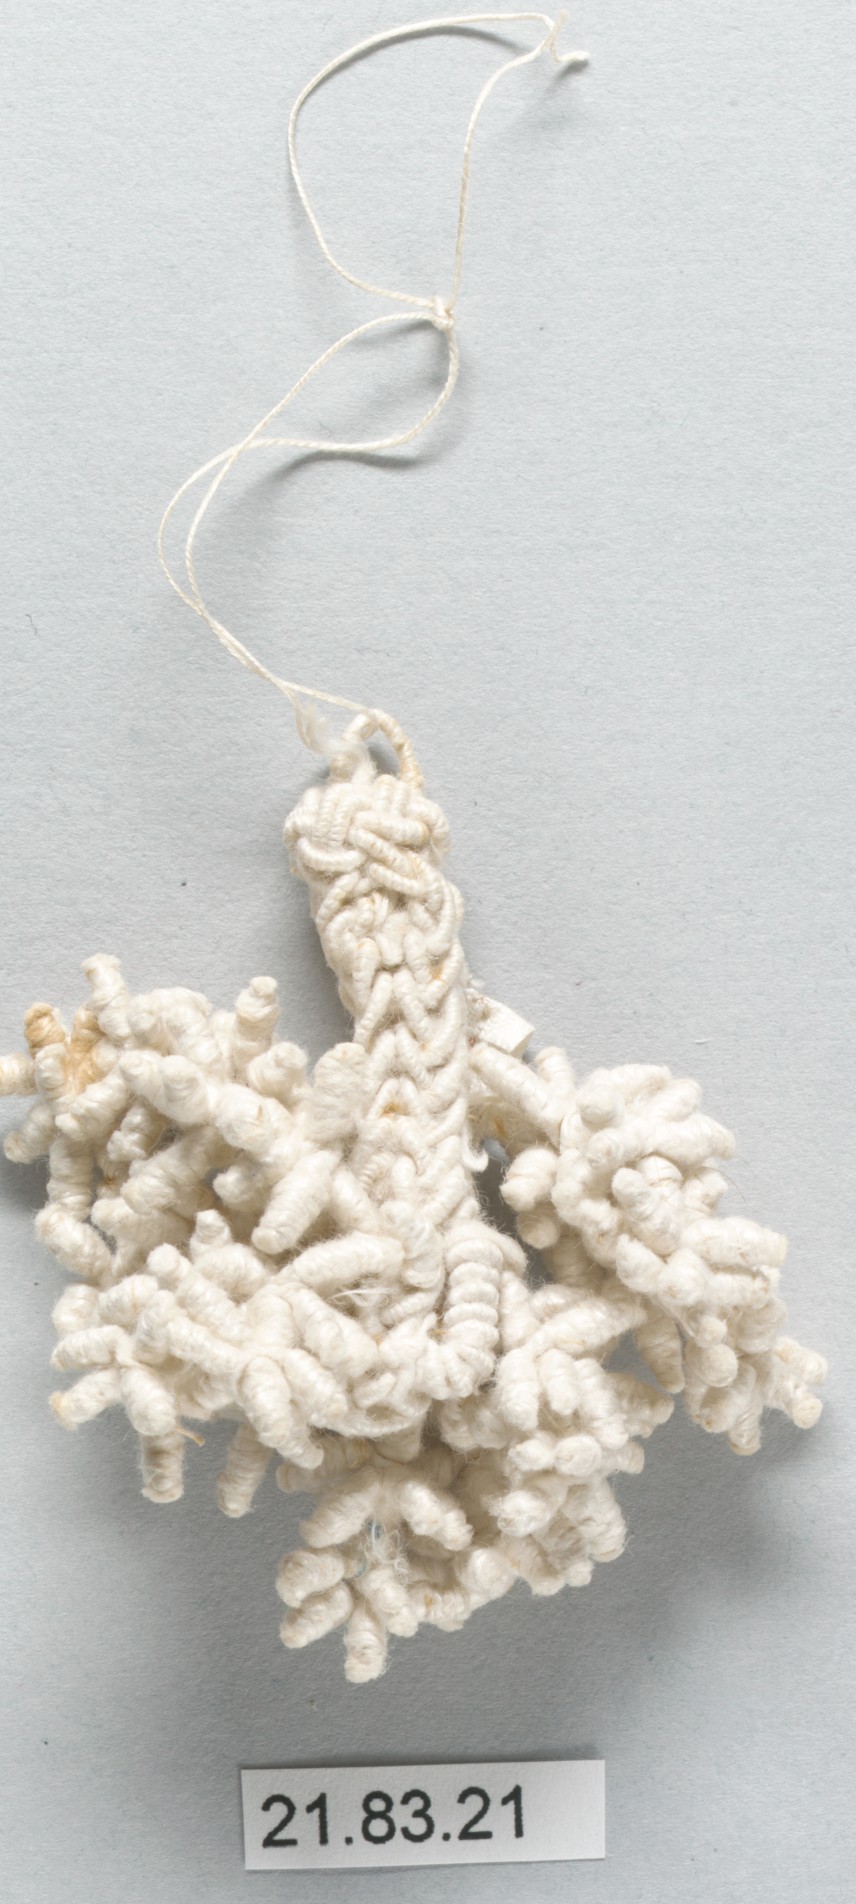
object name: tassel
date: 1601-1700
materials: linen